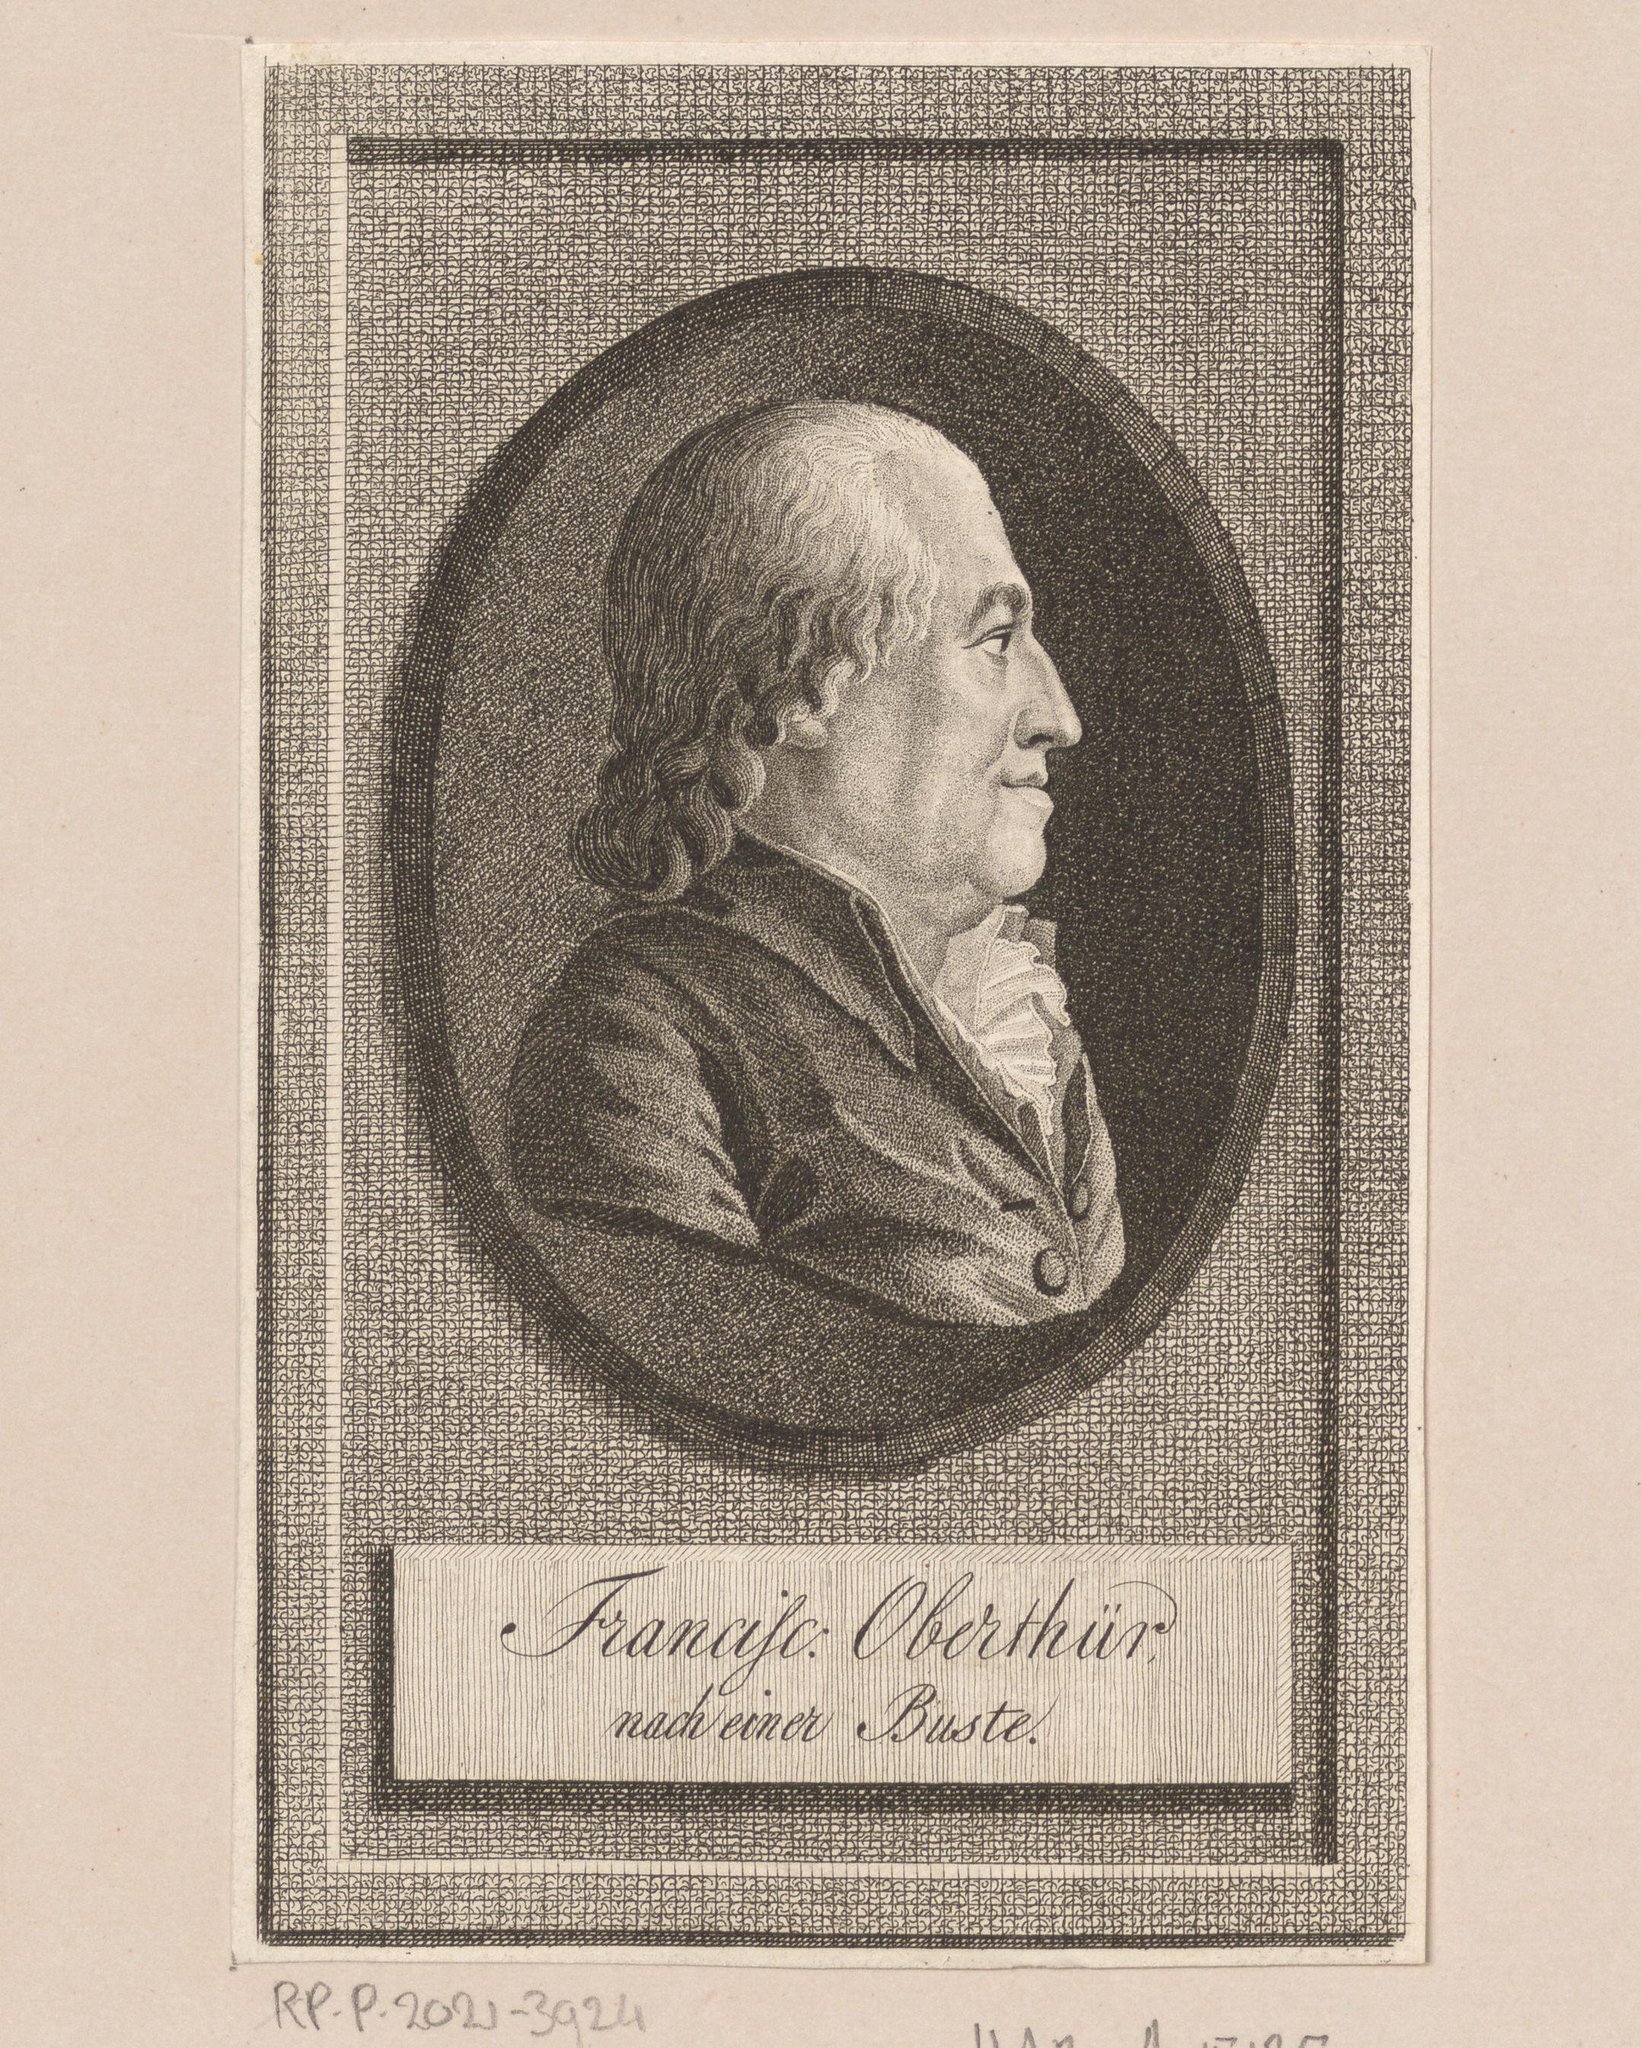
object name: print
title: Portretbuste van Franz Oberthür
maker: Anonymous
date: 1793-1850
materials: paper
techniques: etching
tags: historical persons